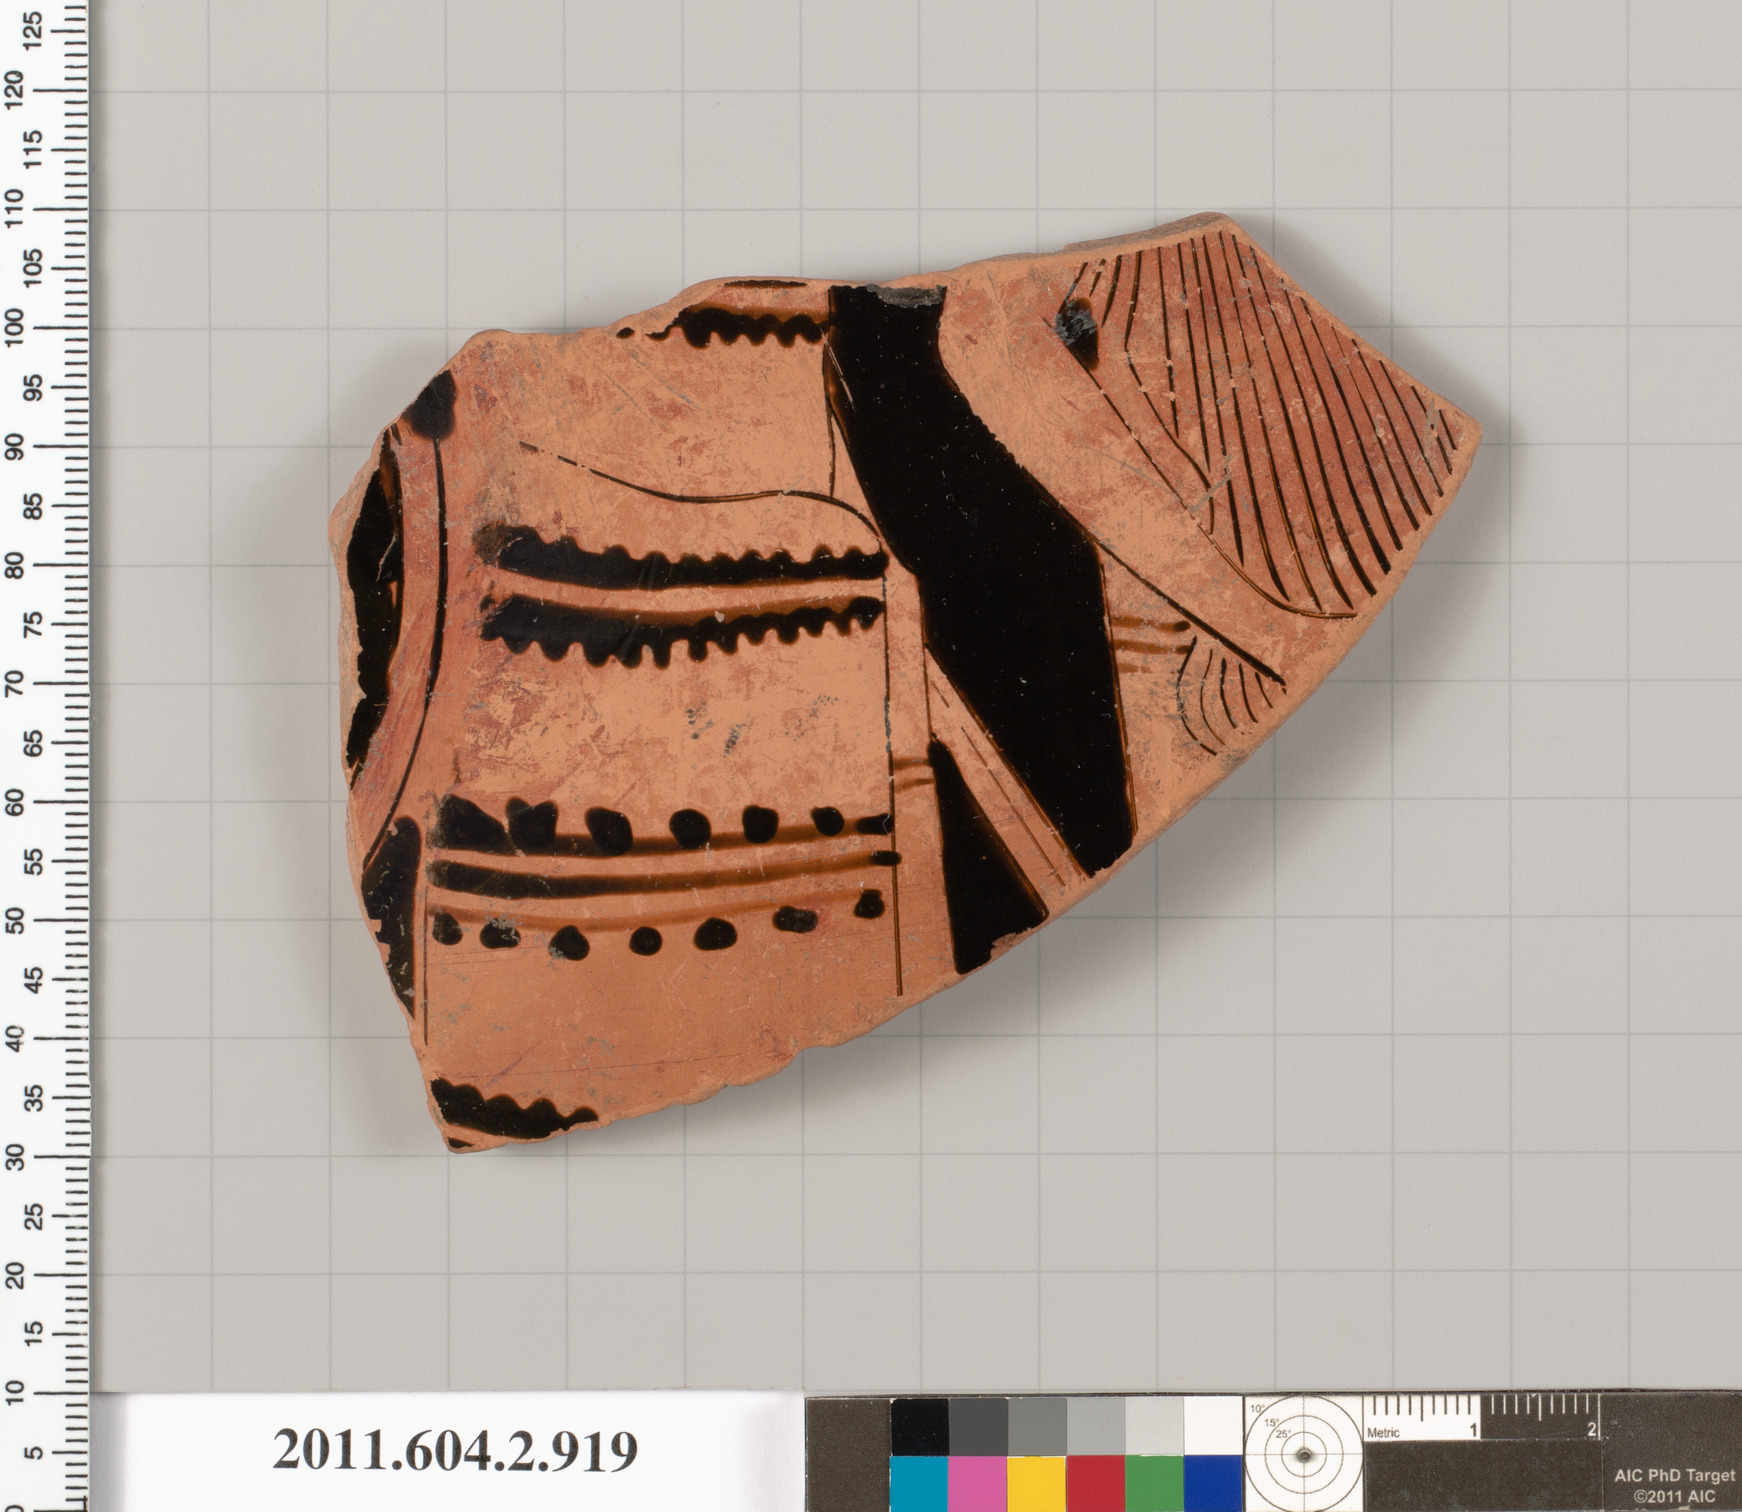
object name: kalpis fragment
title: Terracotta fragment of a hydria: kalpis (water jar)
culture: greek, attic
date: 470-460 BCE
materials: terracotta